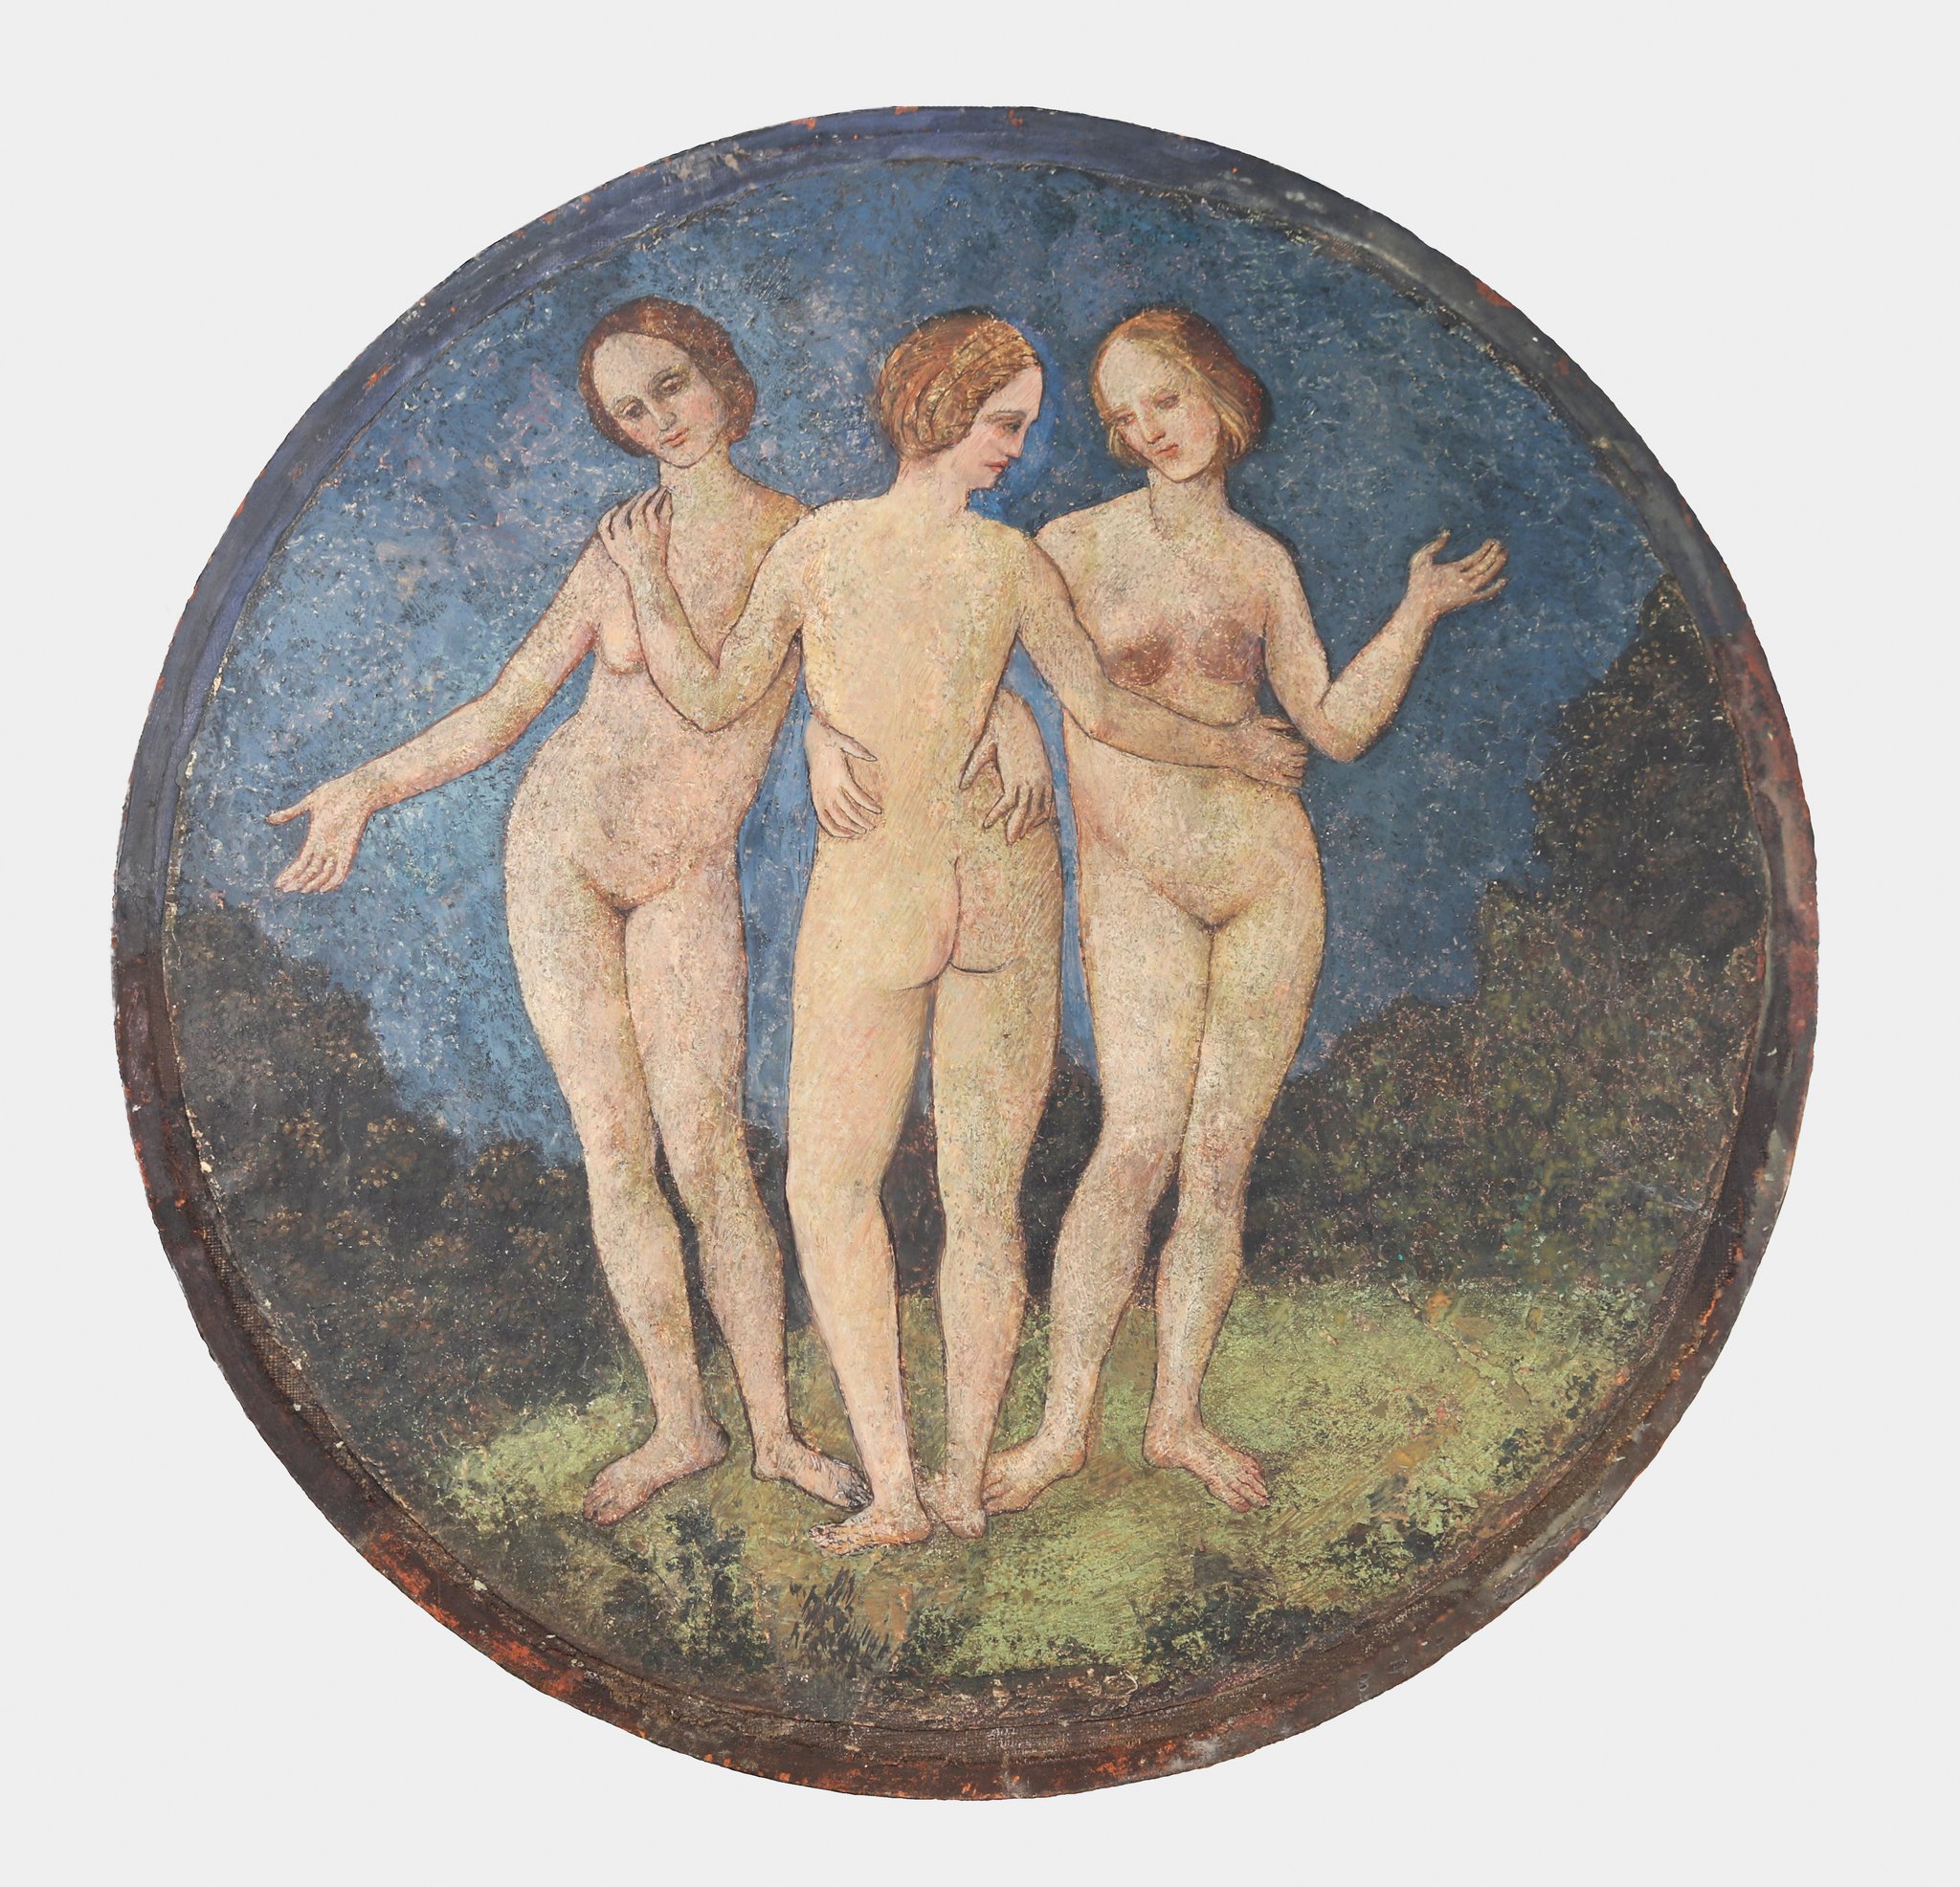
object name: ceiling panel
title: The Three Graces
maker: pinturicchio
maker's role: artist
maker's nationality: italian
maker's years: 1454-1513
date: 1509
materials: canvas, panel, wood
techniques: fresco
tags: female nudes